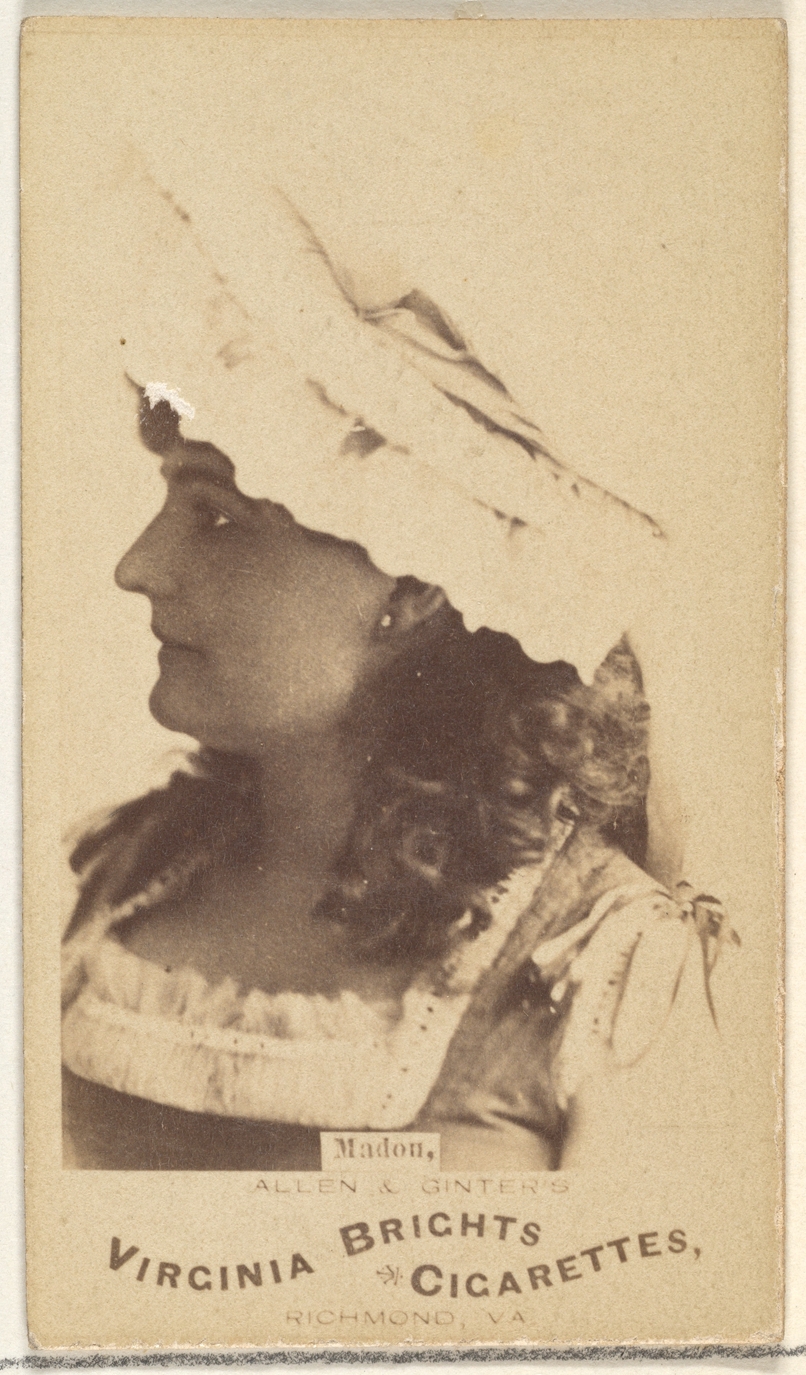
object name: photograph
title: Madon, from the Actors and Actresses series (N45, Type 1) for Virginia Brights Cigarettes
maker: allen & ginter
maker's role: publisher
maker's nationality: american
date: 1888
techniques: albumen silver print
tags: portraits,profiles,women,actresses